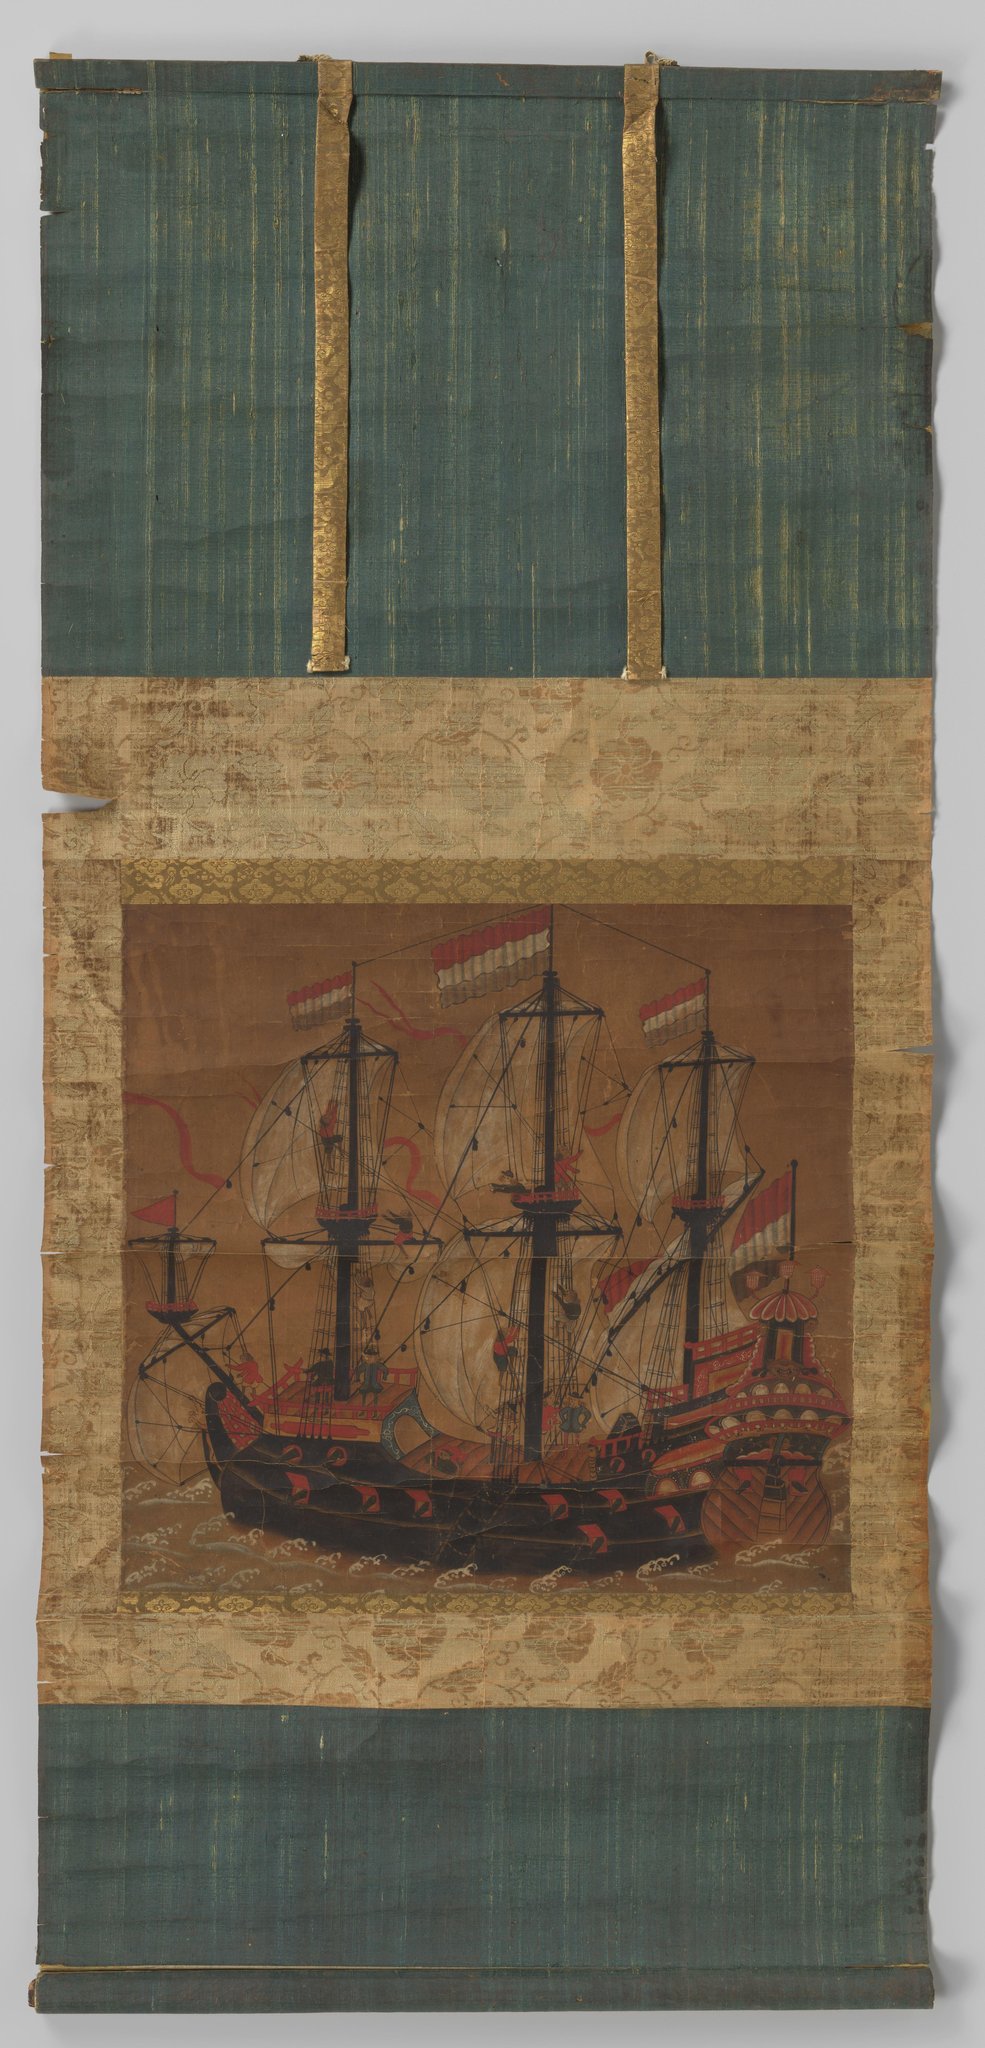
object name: hanging scroll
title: Kakemono Nederlands schip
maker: Anonymous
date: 1700-1800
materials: paper, paint, silk, wood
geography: japan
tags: sailing-ship, sailing-boat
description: Langwerpige rol zijde waarop in het midden op bruin papier schildering van (Nederlands) schip met bemanning, driemaster onder zeil. v.r.n.l. voor de wind varend, met Hollandse vlaggen in top; boven en beneden omlijst door goudgebloemde zijde, hieromheen witte zijde, aan boven- en onderzijde groen-blauwe zijde, boven twee goudgebloemde zijden linten, beneden en boven houten rol.